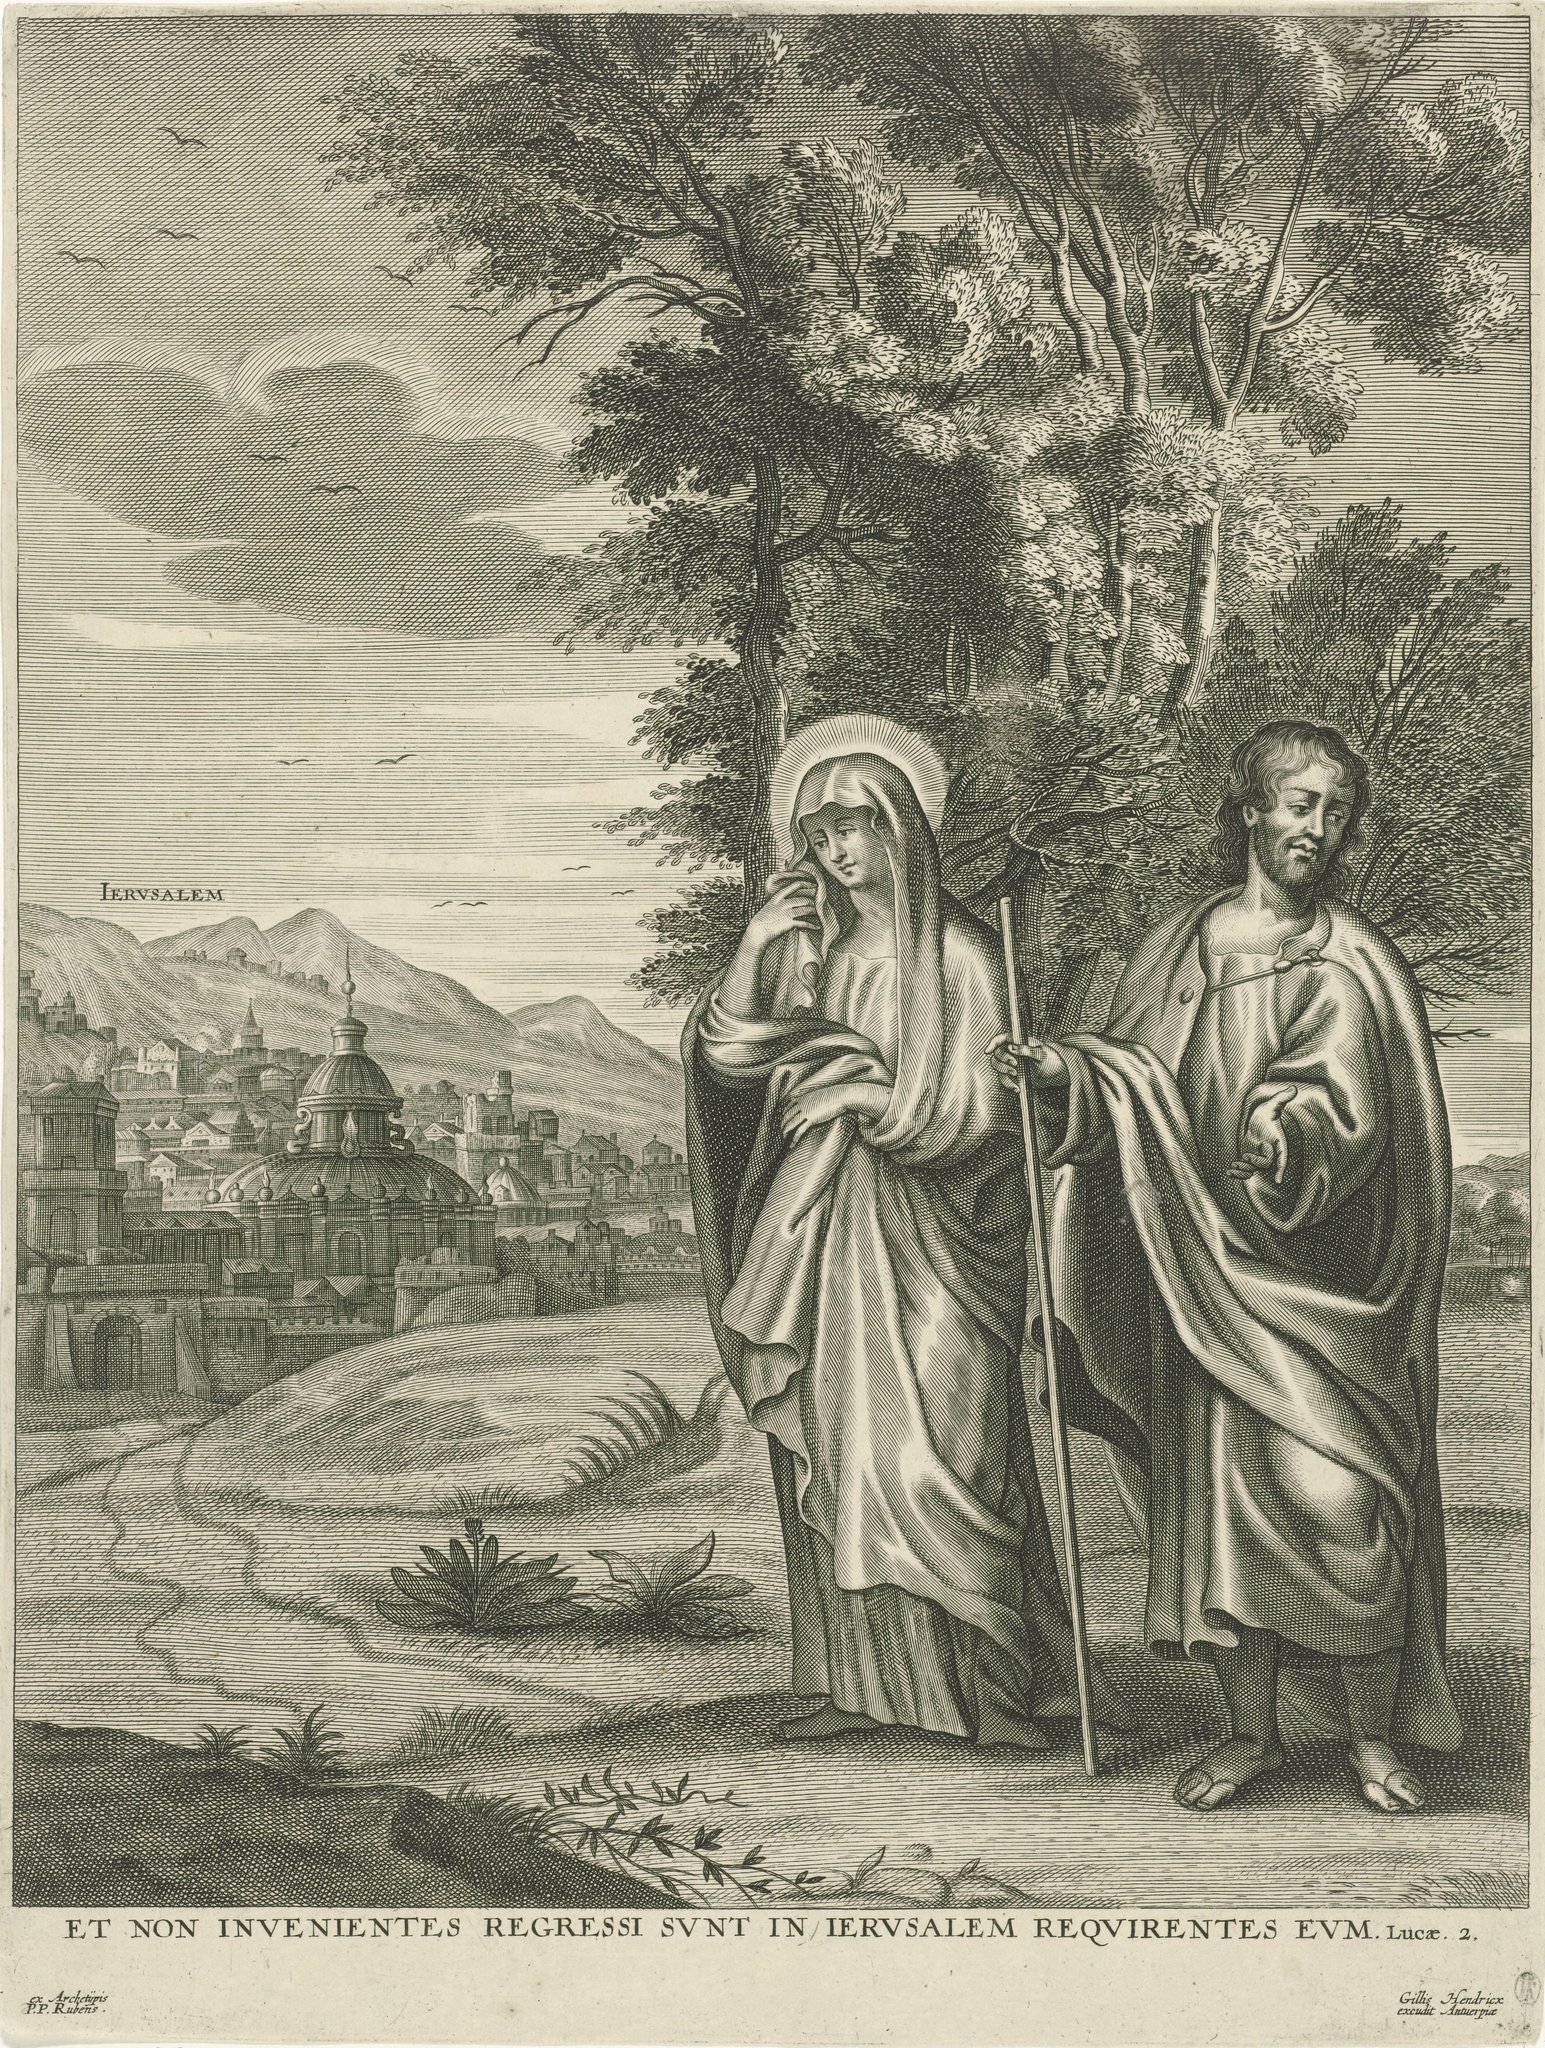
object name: print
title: Terugkeer naar Jeruzalem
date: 1630-1677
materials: paper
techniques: engraving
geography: antwerp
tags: the holy family (and sometimes others) returning to israel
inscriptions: collector's mark: Lugt 2228, collector's mark: Lugt 972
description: Jozef en Maria keren terug naar Jeruzalem. De stad is links in de verte te zien. In de marge een bijbelvers in Latijn.